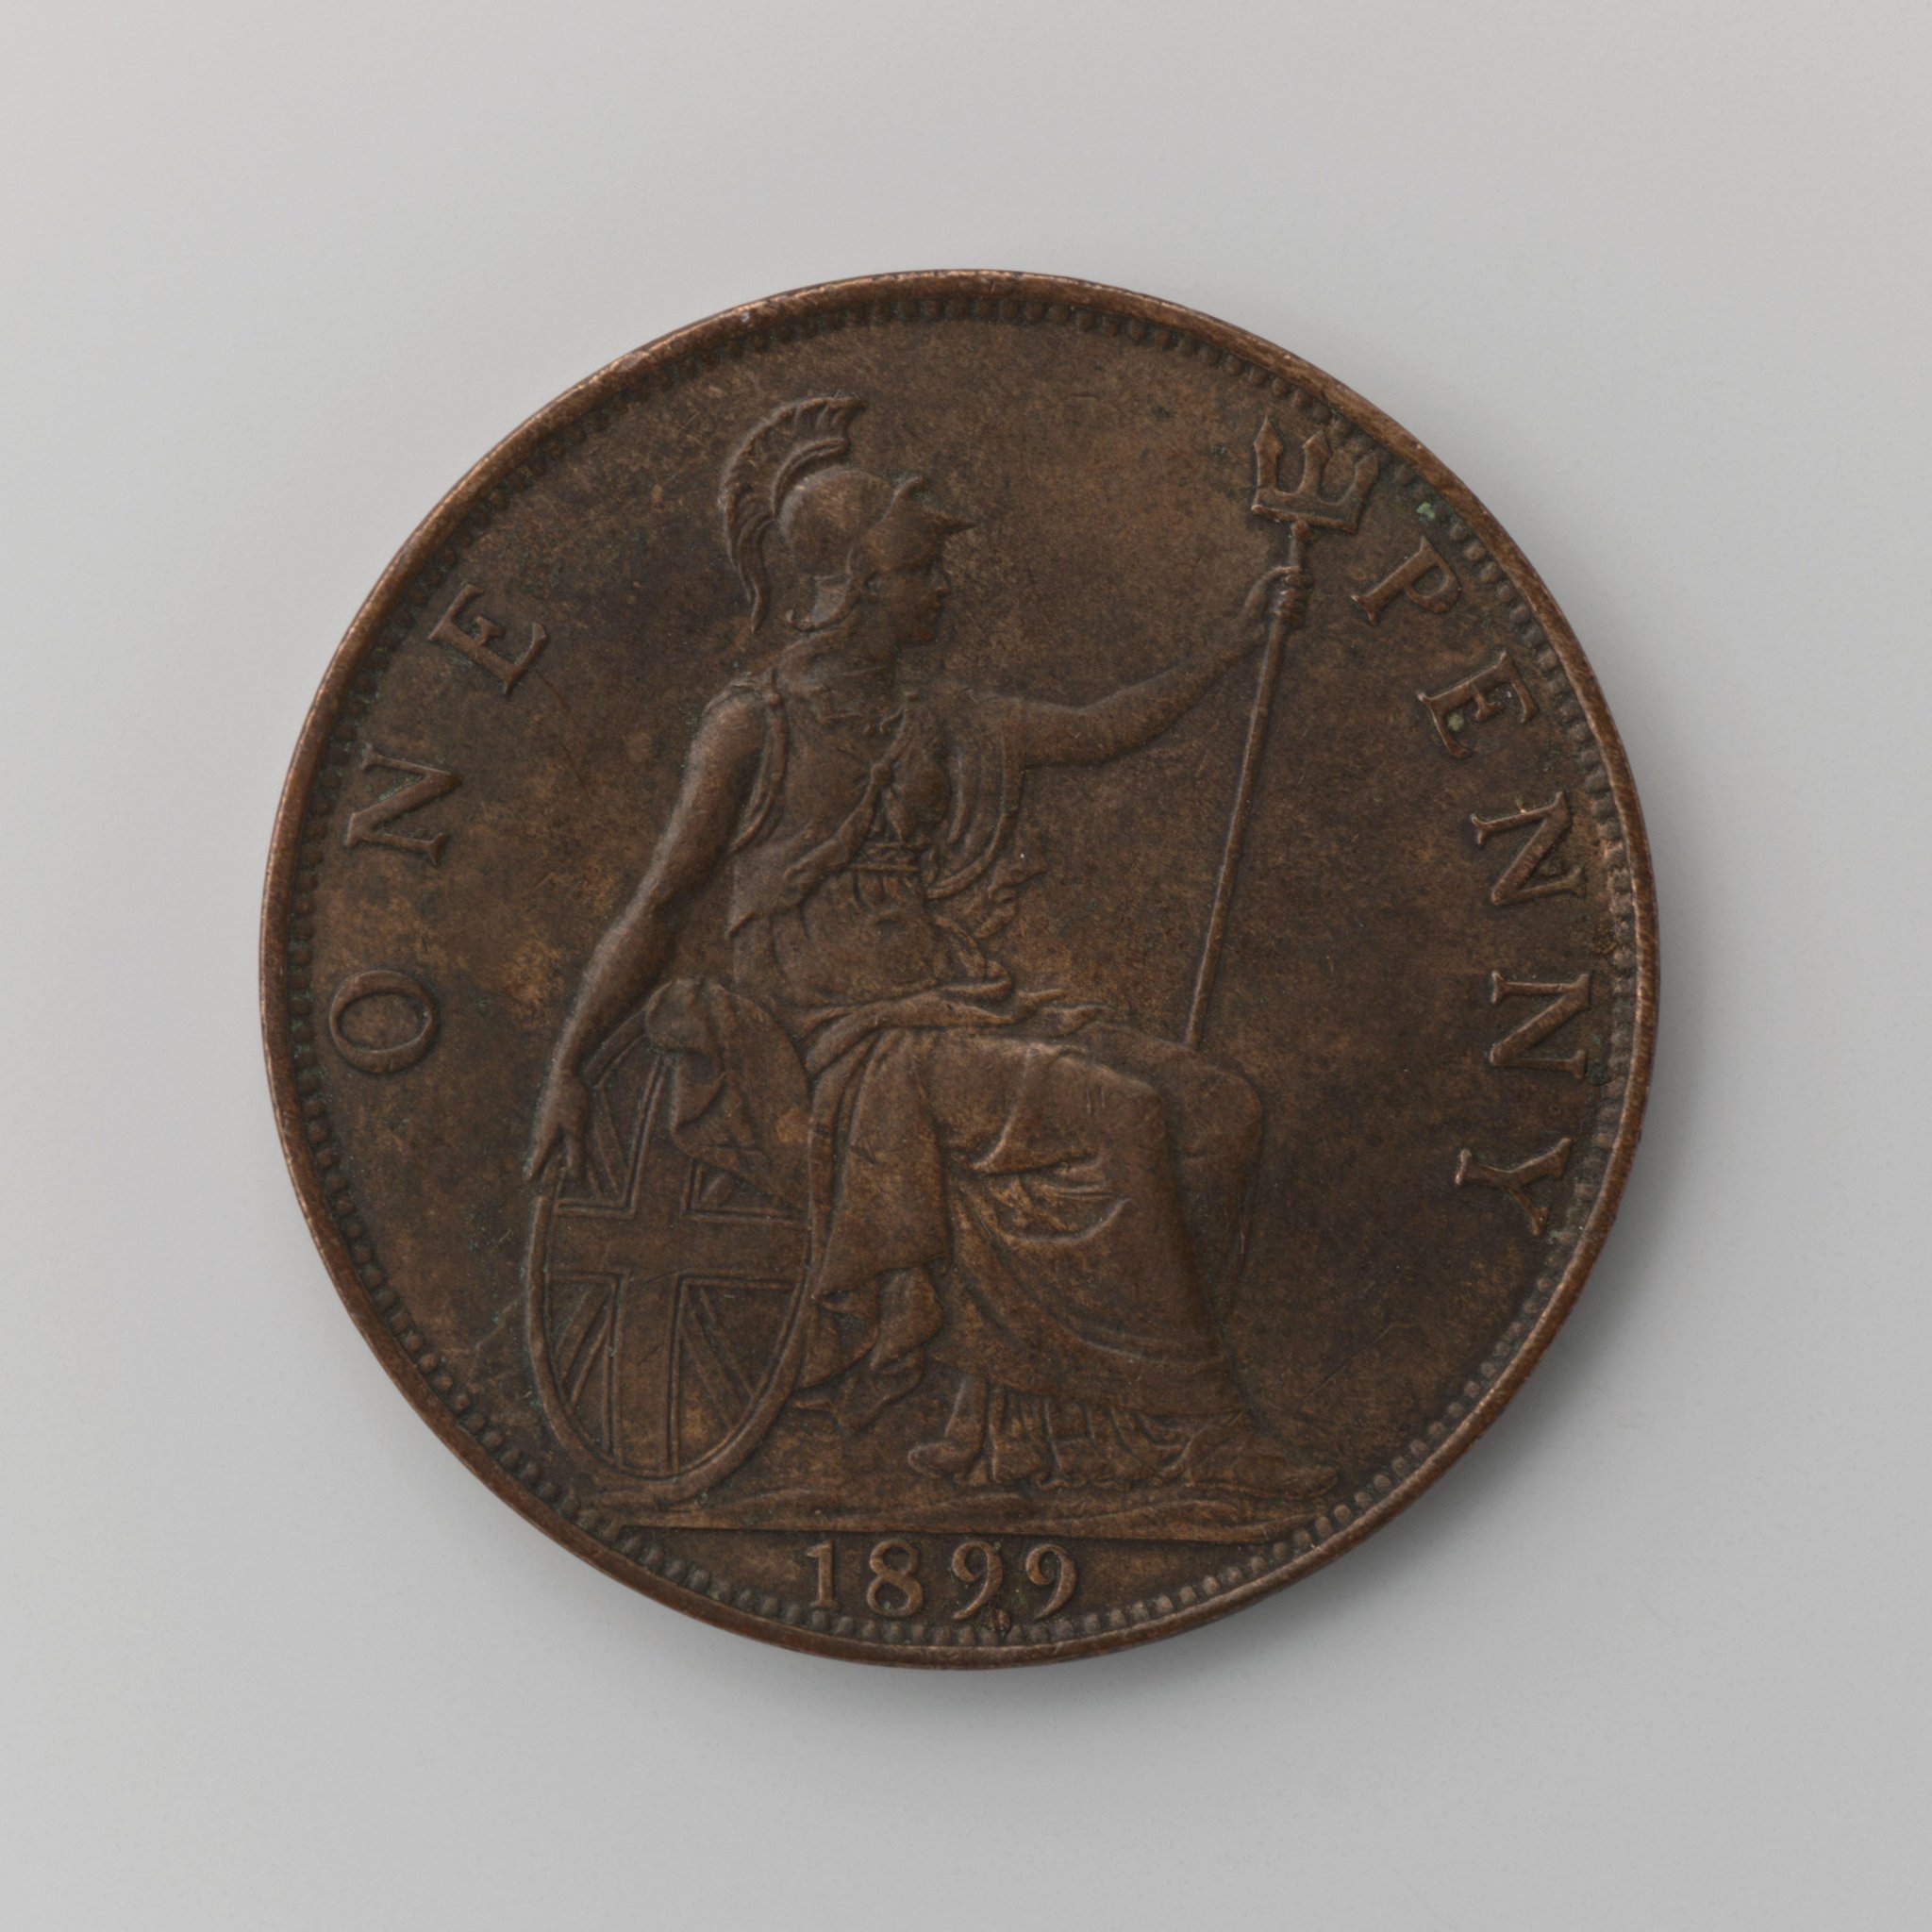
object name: coin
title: Engeland, Victoria, penny, 1899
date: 1862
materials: bronze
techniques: striking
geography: london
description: Bronzen munt. Voorzijde:gekroond borstbeeld van de koningin naar links [old head]. Keerzijde: tegen wapenschild gezeten Brittannia met drietand, naar rechts. In afsnede jaartal. Waarde-aanduiding als omschrift. Gladde rand.